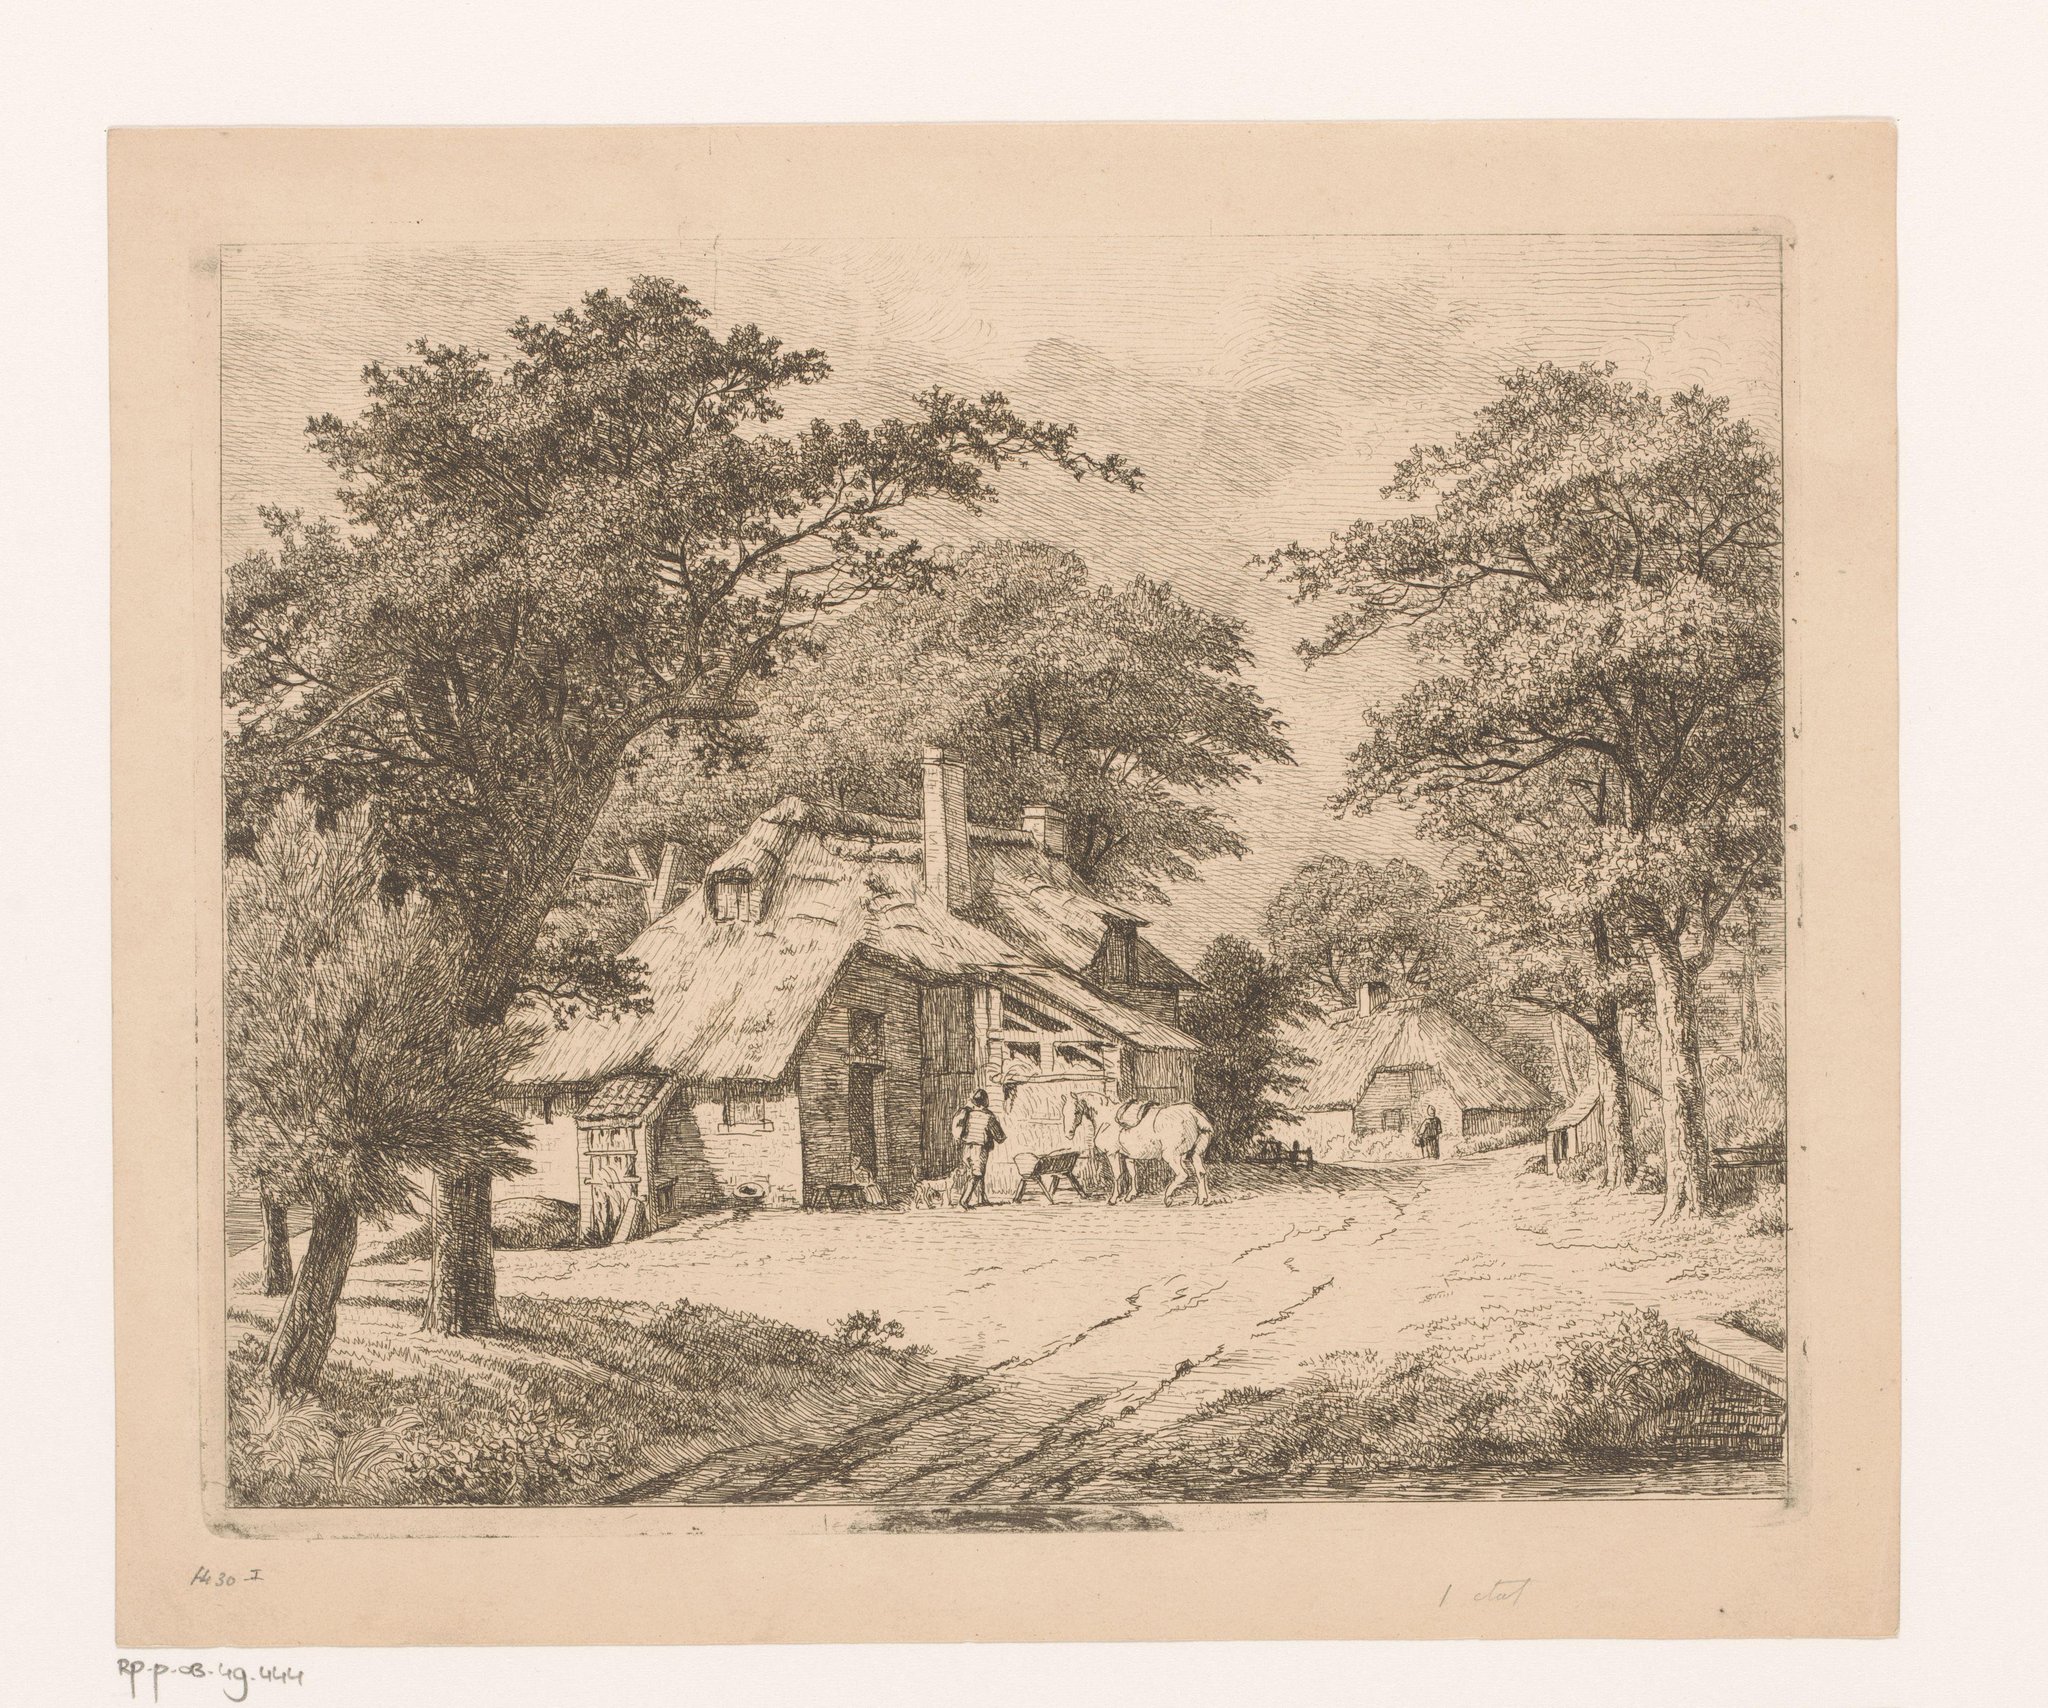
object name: print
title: Wit paard bij een voerbak voor een boerderij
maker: hendrik jozef franciscus van der poorten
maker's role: draughtsman, print maker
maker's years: 1789-1874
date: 1842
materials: paper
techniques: etching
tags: trough, horse, farm or solitary house in landscape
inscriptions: collector's mark: Lugt 2228, annotation: ‘1 etat’, annotation: ‘H v d Poorten 1ste druk’